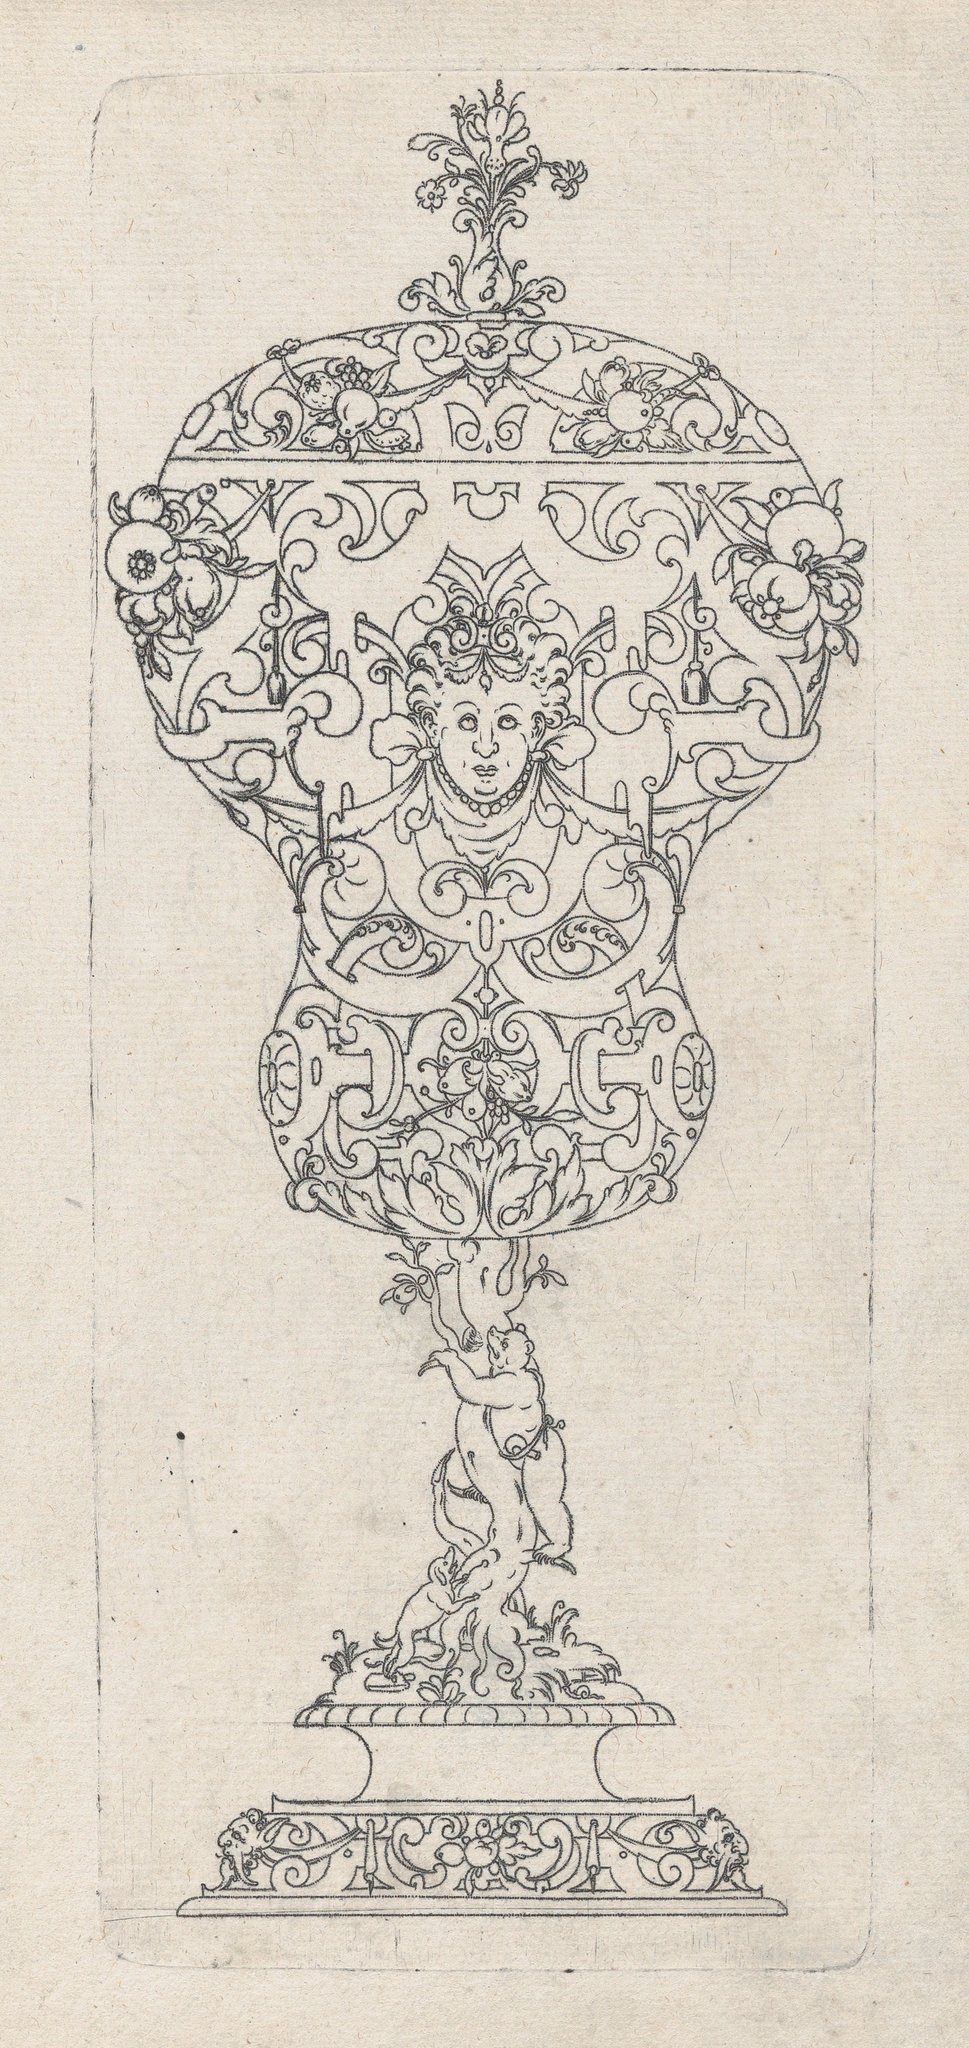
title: Covered Goblet, Pear shaped bidy on shaft og twisted tree-trunk with bear treed by dog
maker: jonas silber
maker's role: artist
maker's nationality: german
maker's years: 1572-1590